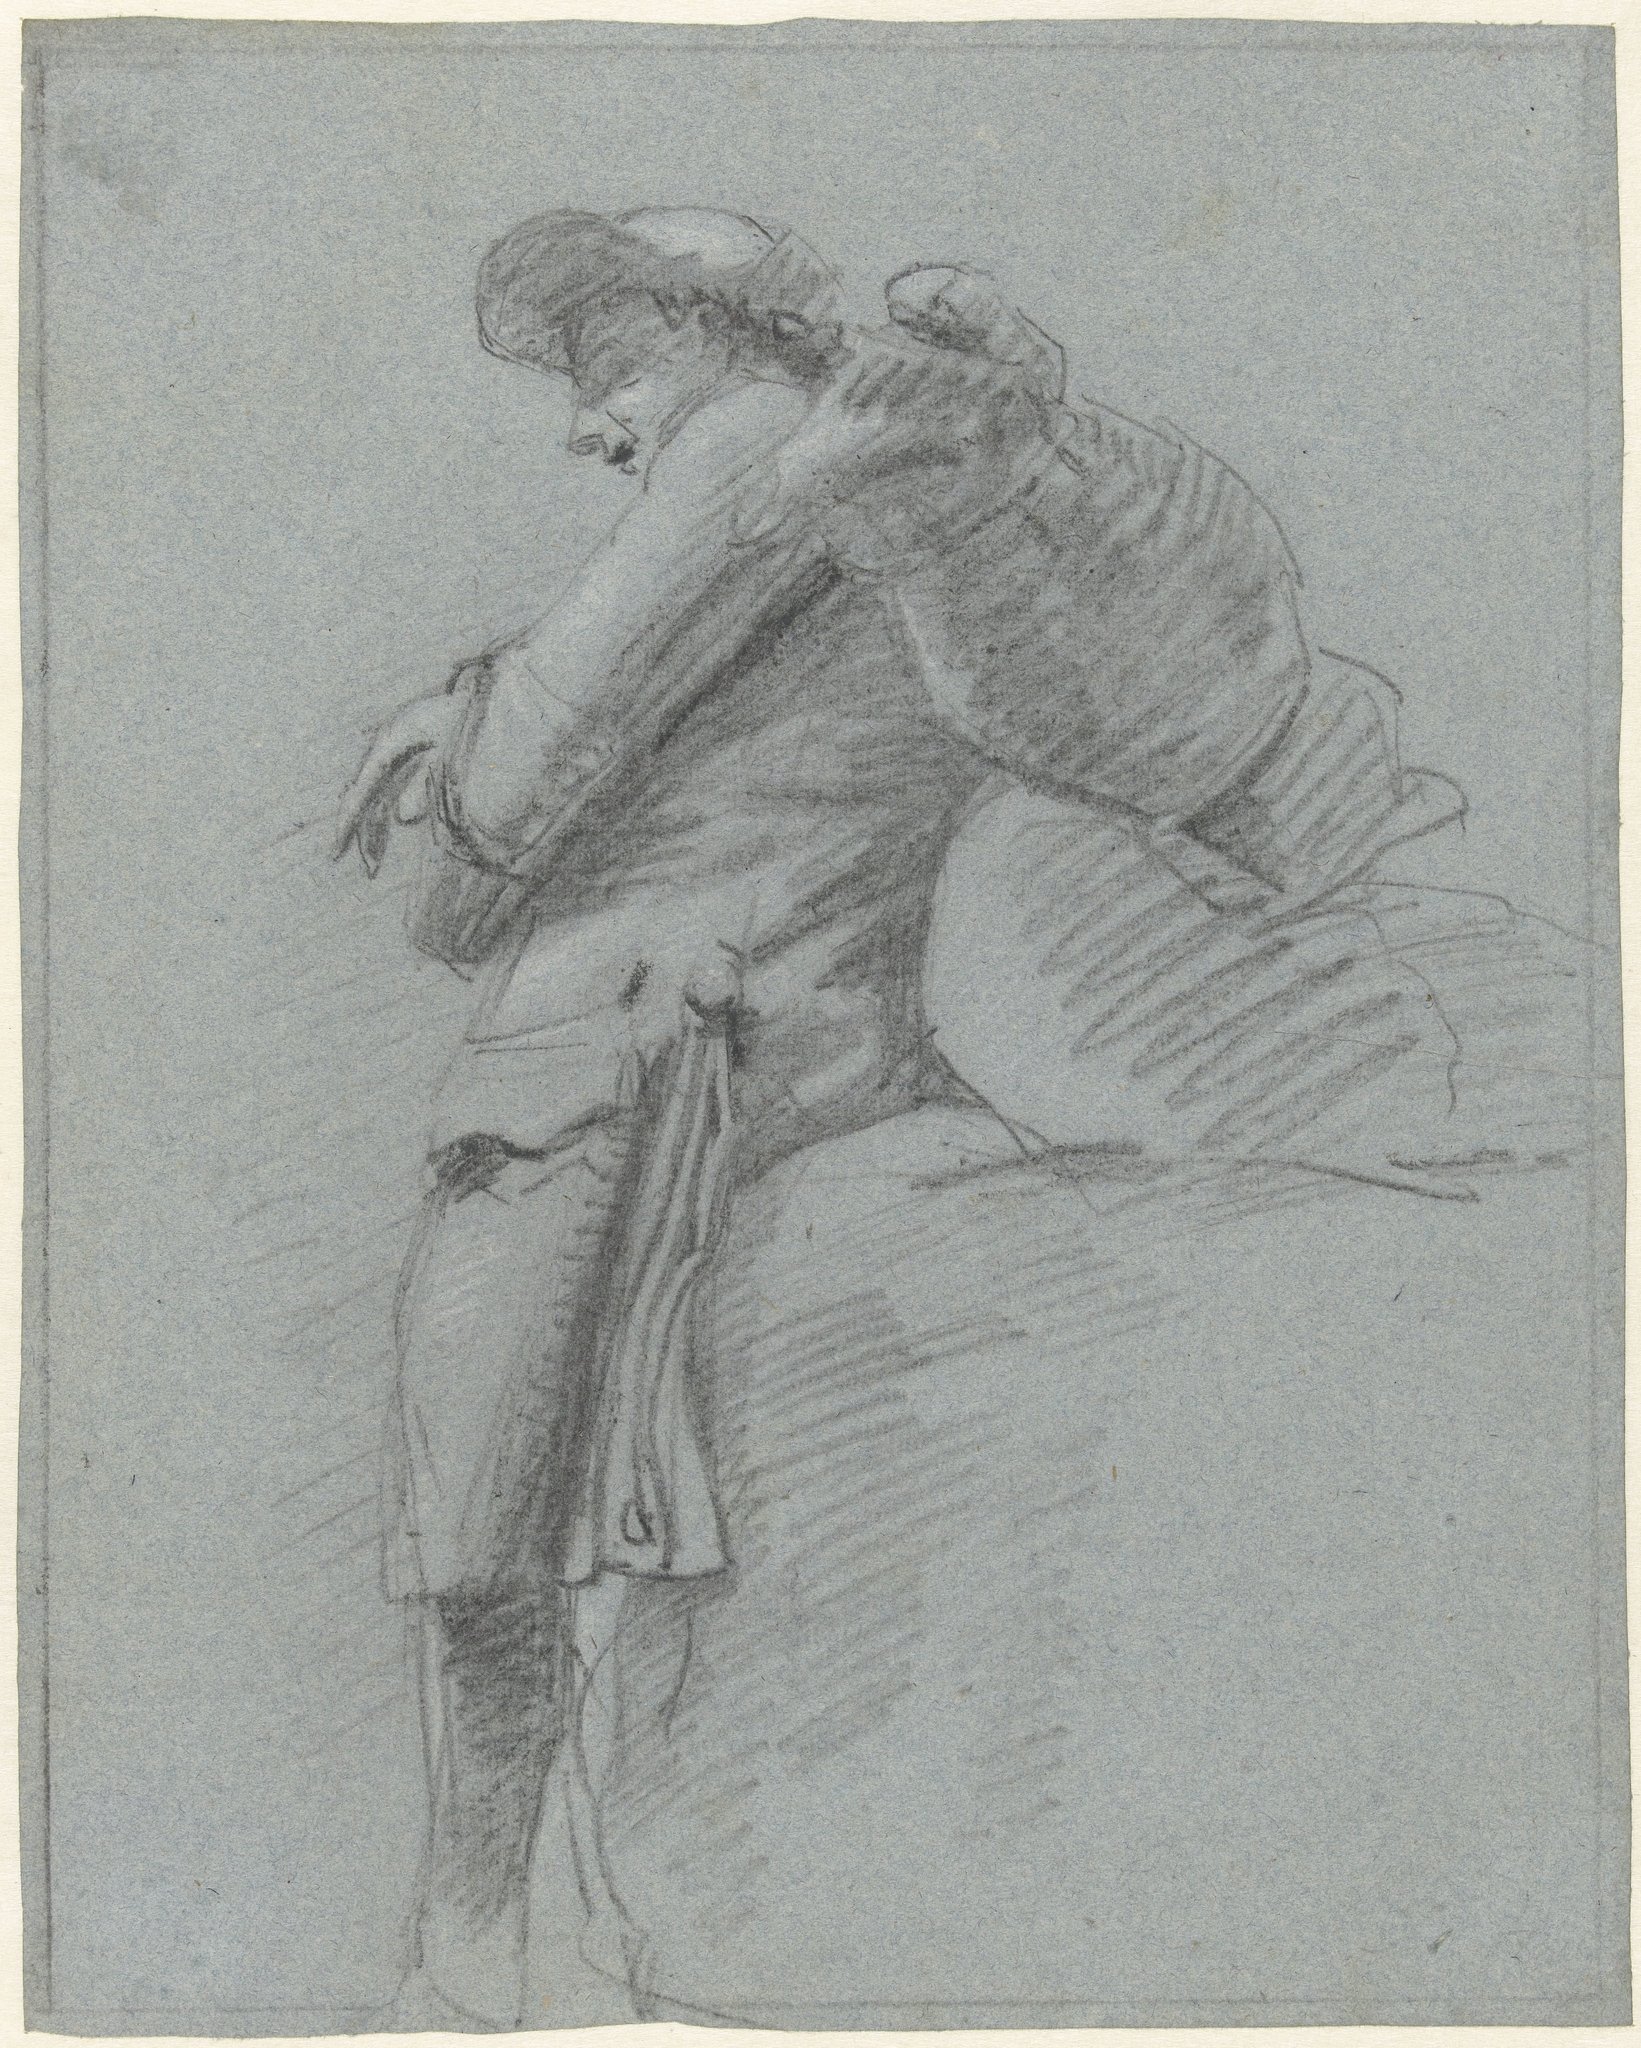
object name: drawing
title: Staande man met een pak op de rug, geleund tegen een verhoging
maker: jordanus hoorn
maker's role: draughtsman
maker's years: 1753-1833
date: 1763-1833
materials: chalk, paper